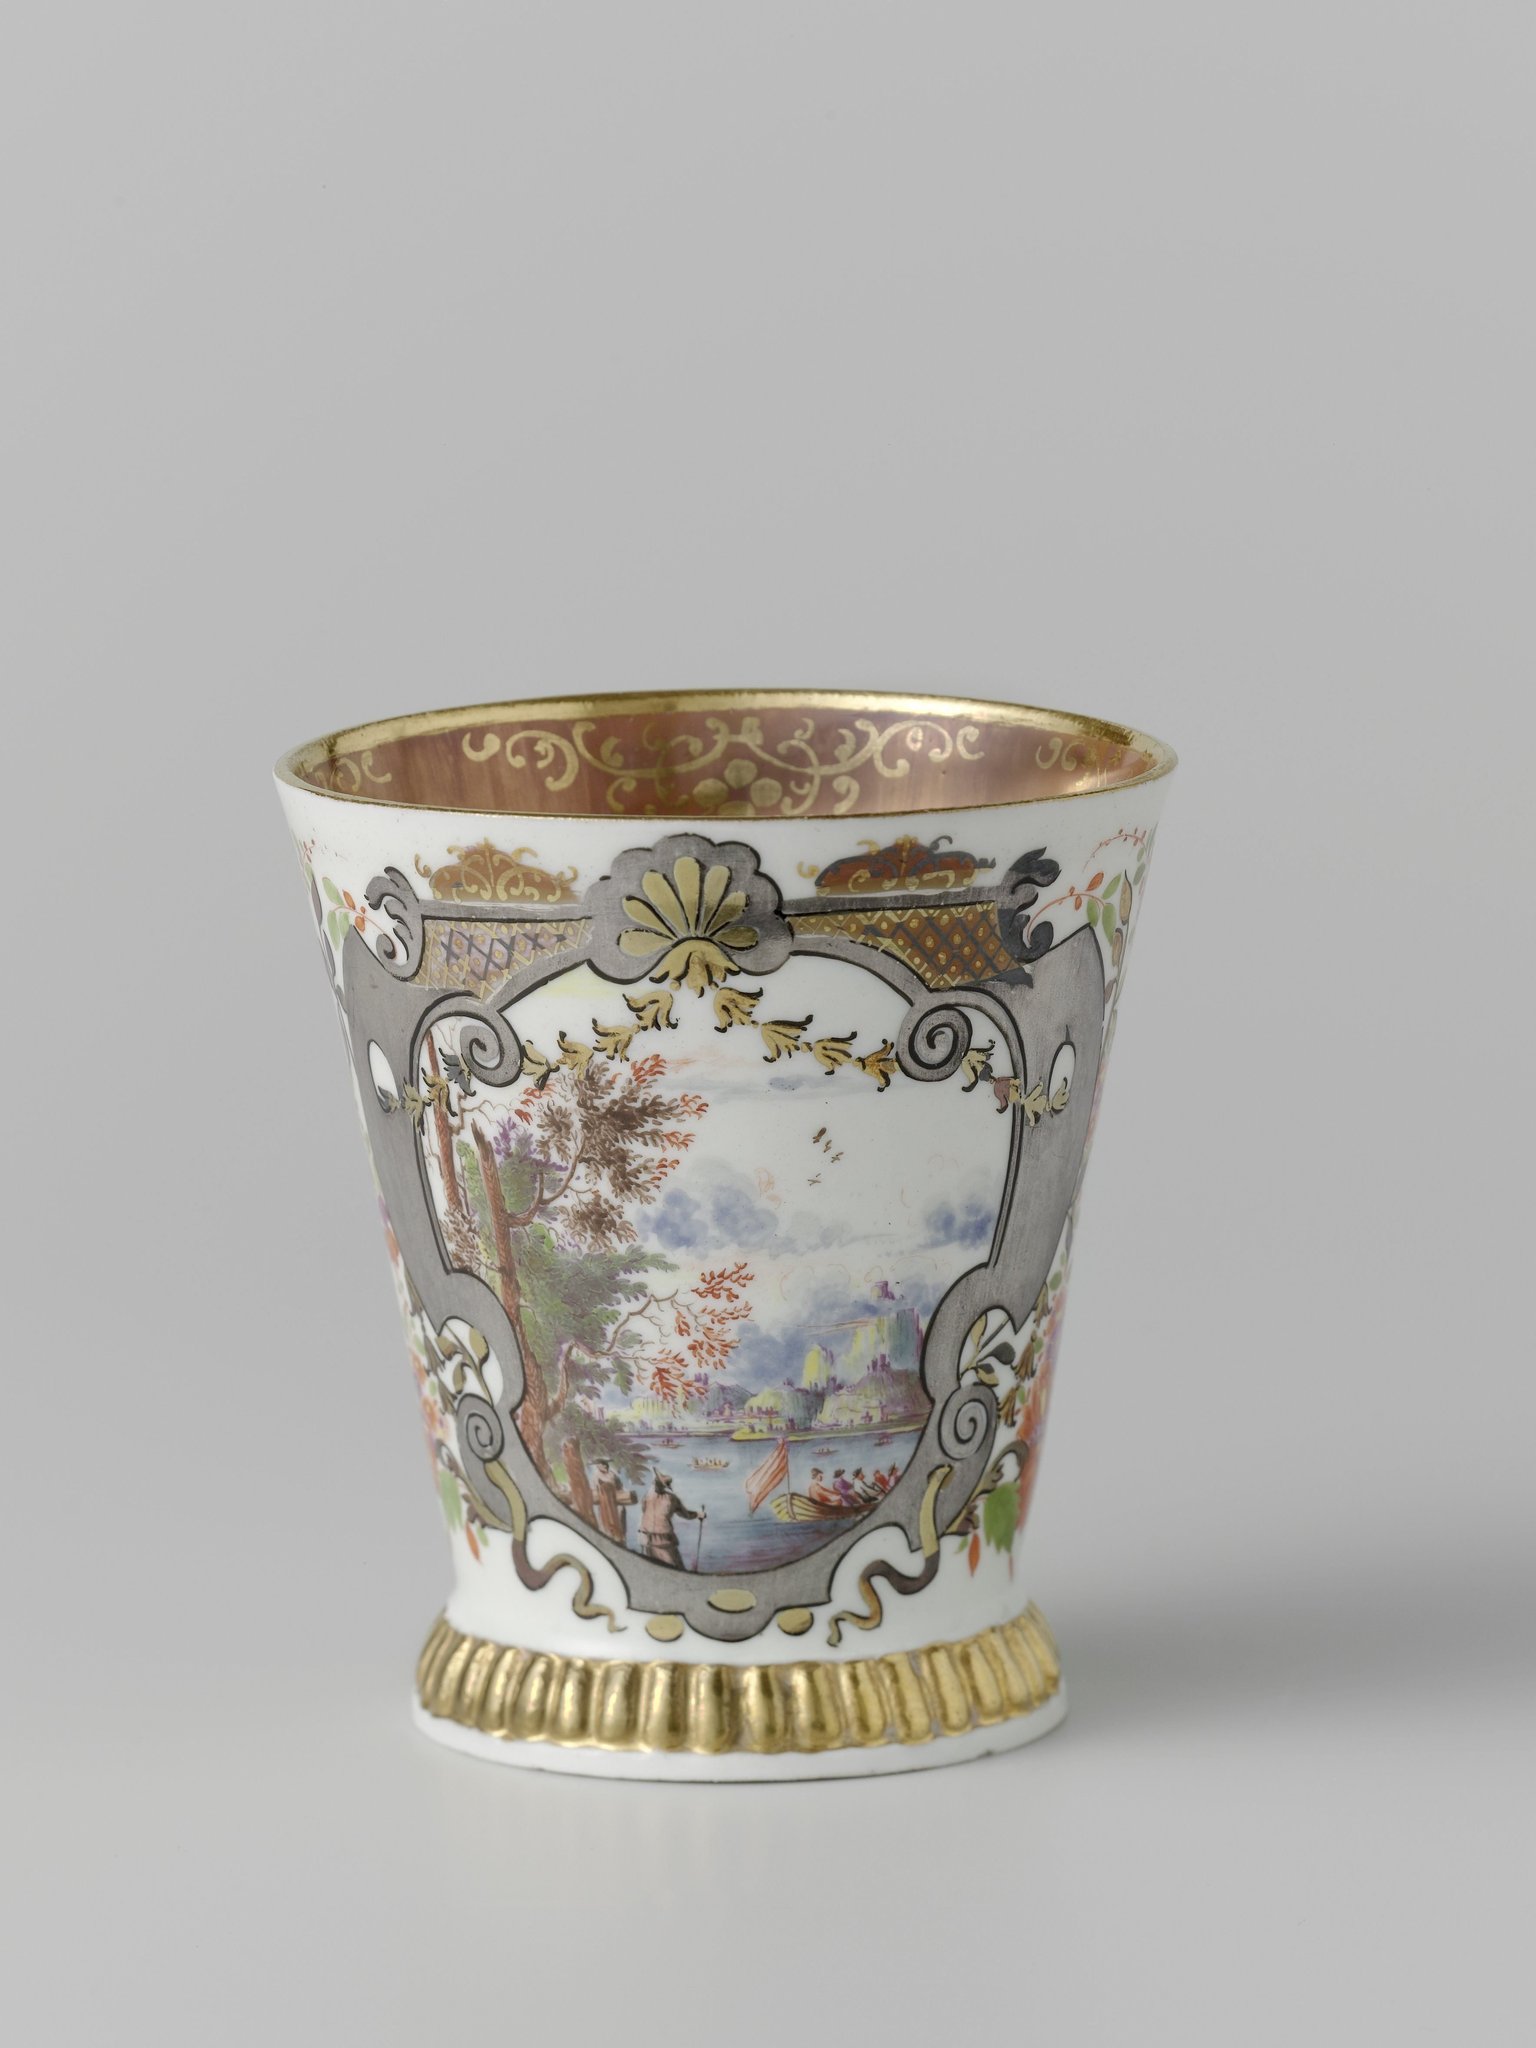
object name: cup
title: Beker, veelkleurig beschilderd met een riviergezicht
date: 1725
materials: porcelain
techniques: painted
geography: meissen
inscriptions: factory mark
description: Beaker. Porcelain. Meissen, c. 1725.